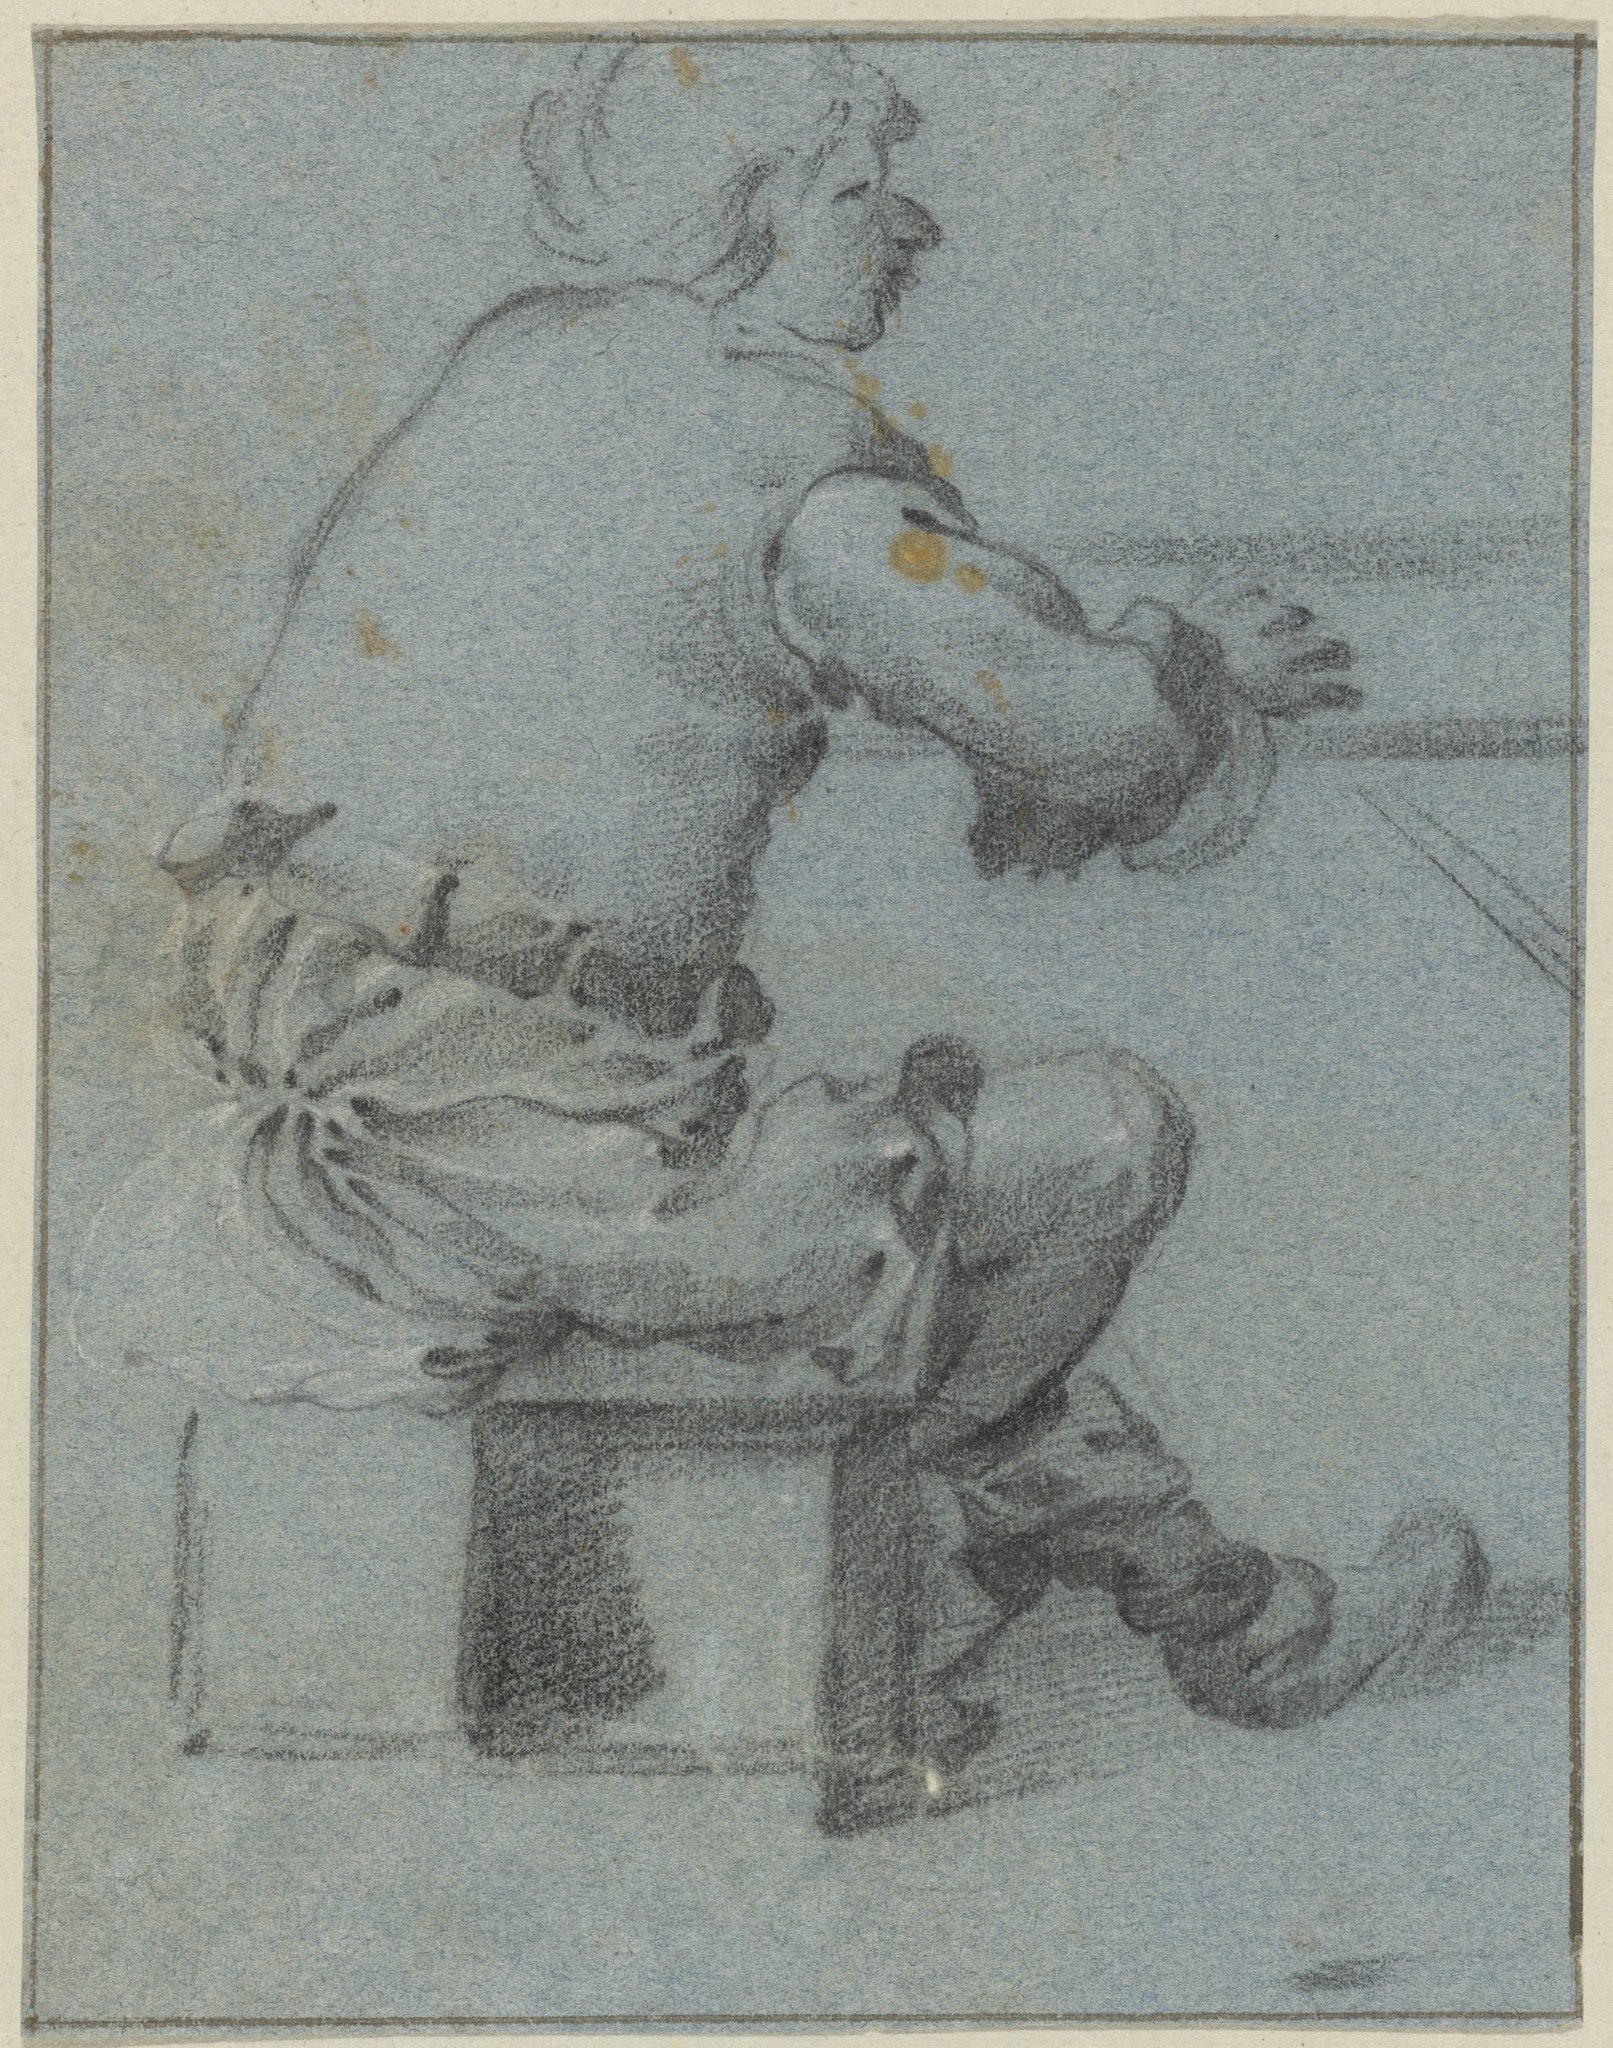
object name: drawing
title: Zittende man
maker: Anonymous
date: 1600-1699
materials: chalk, paper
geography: netherlands